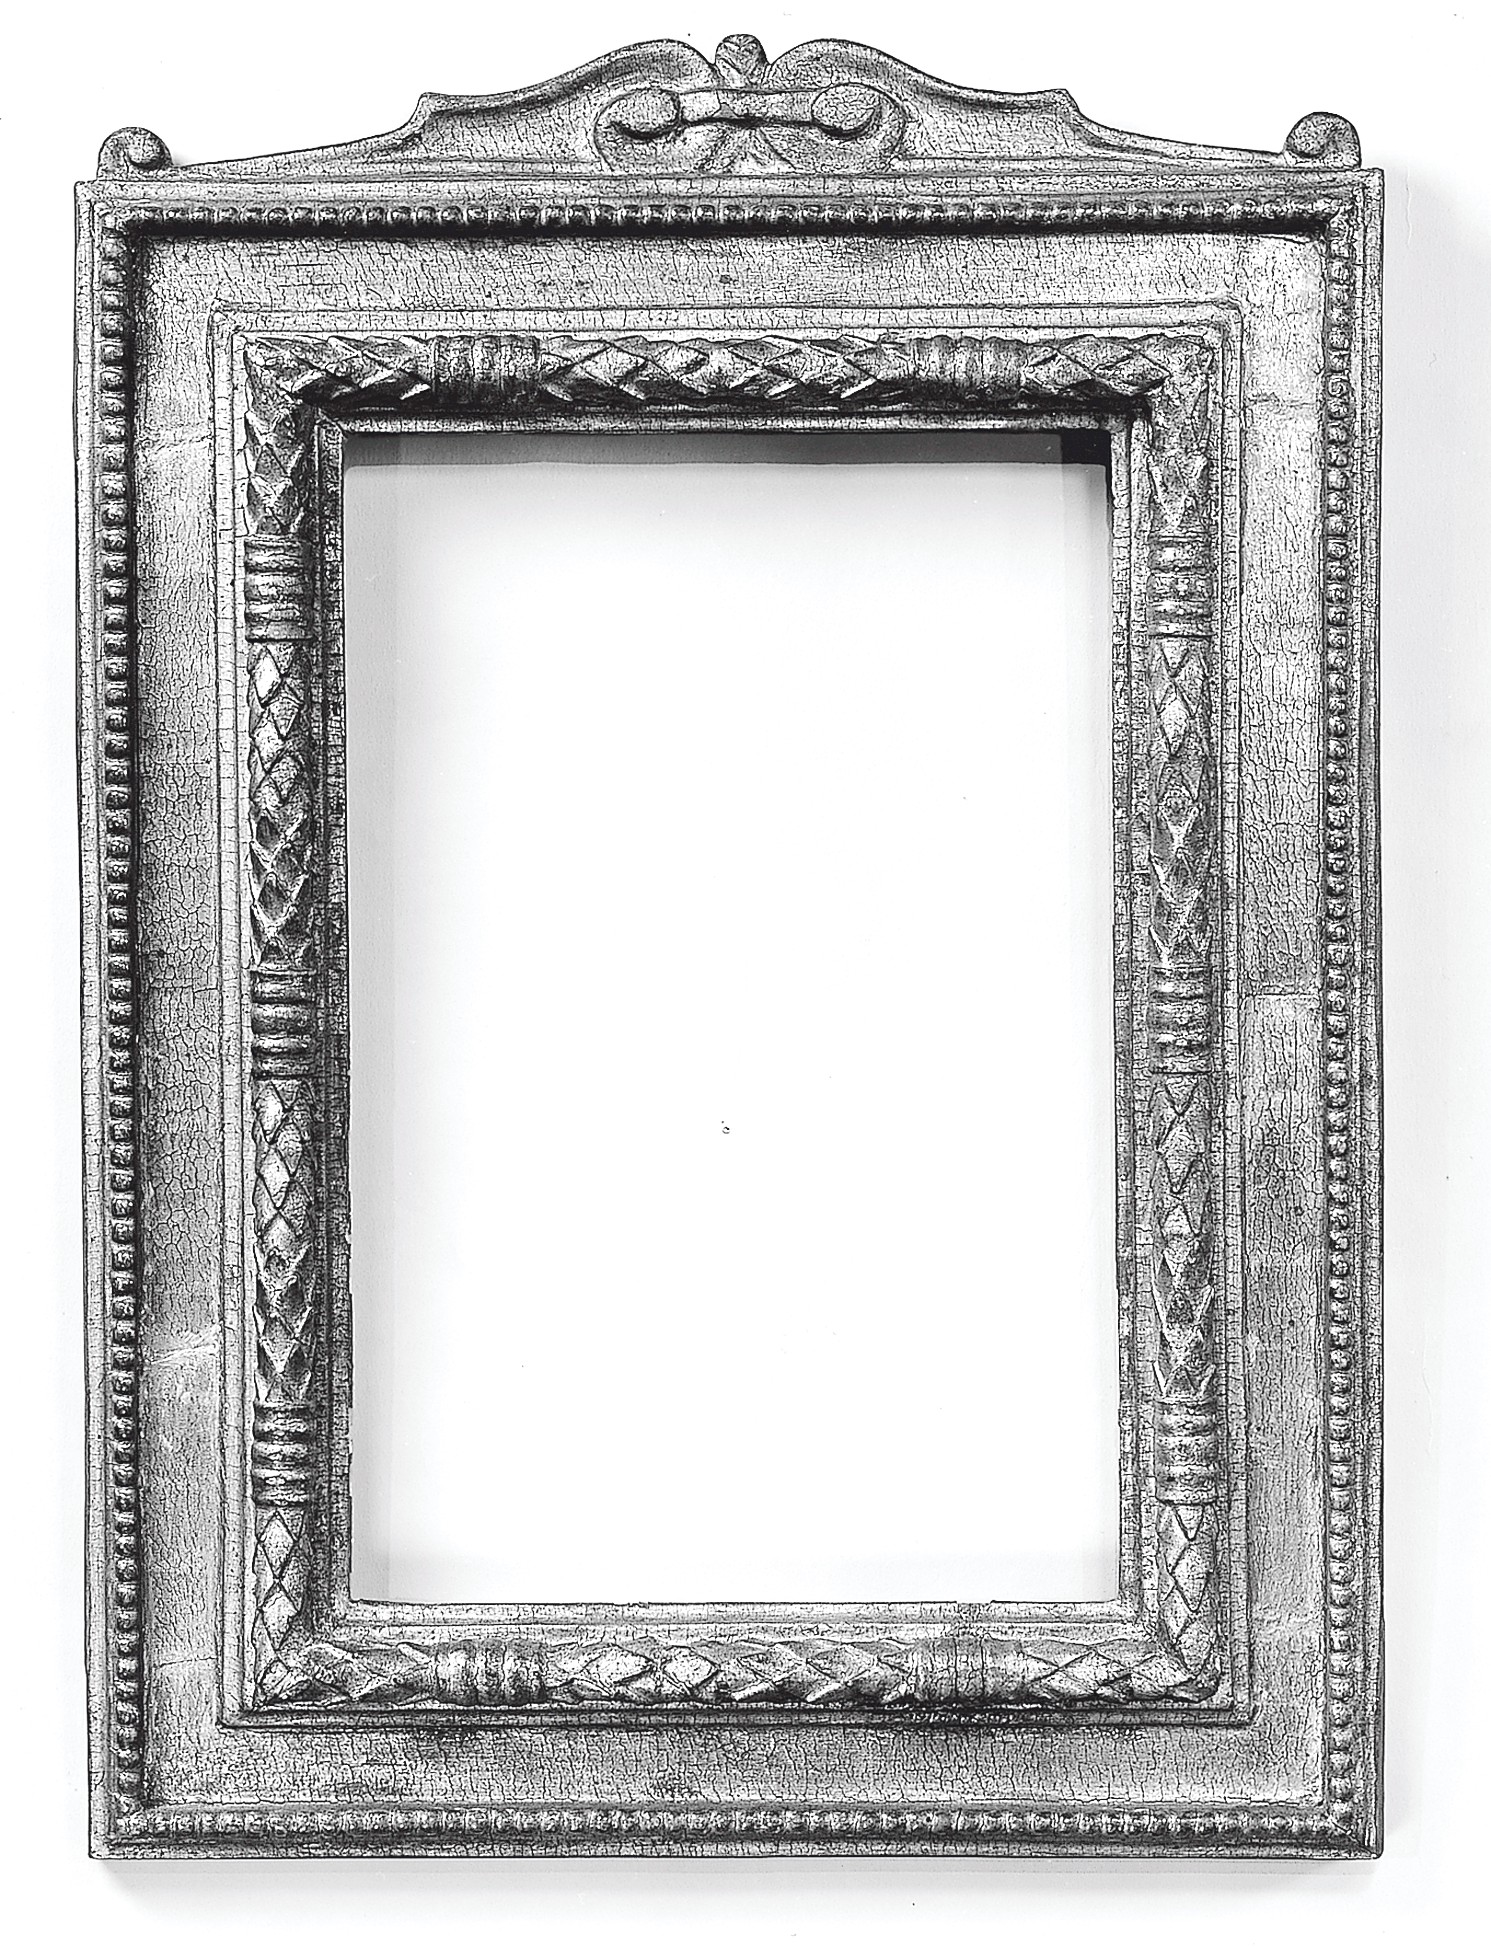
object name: frame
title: Reverse cassetta mirror frame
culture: southern italian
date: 1950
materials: wood